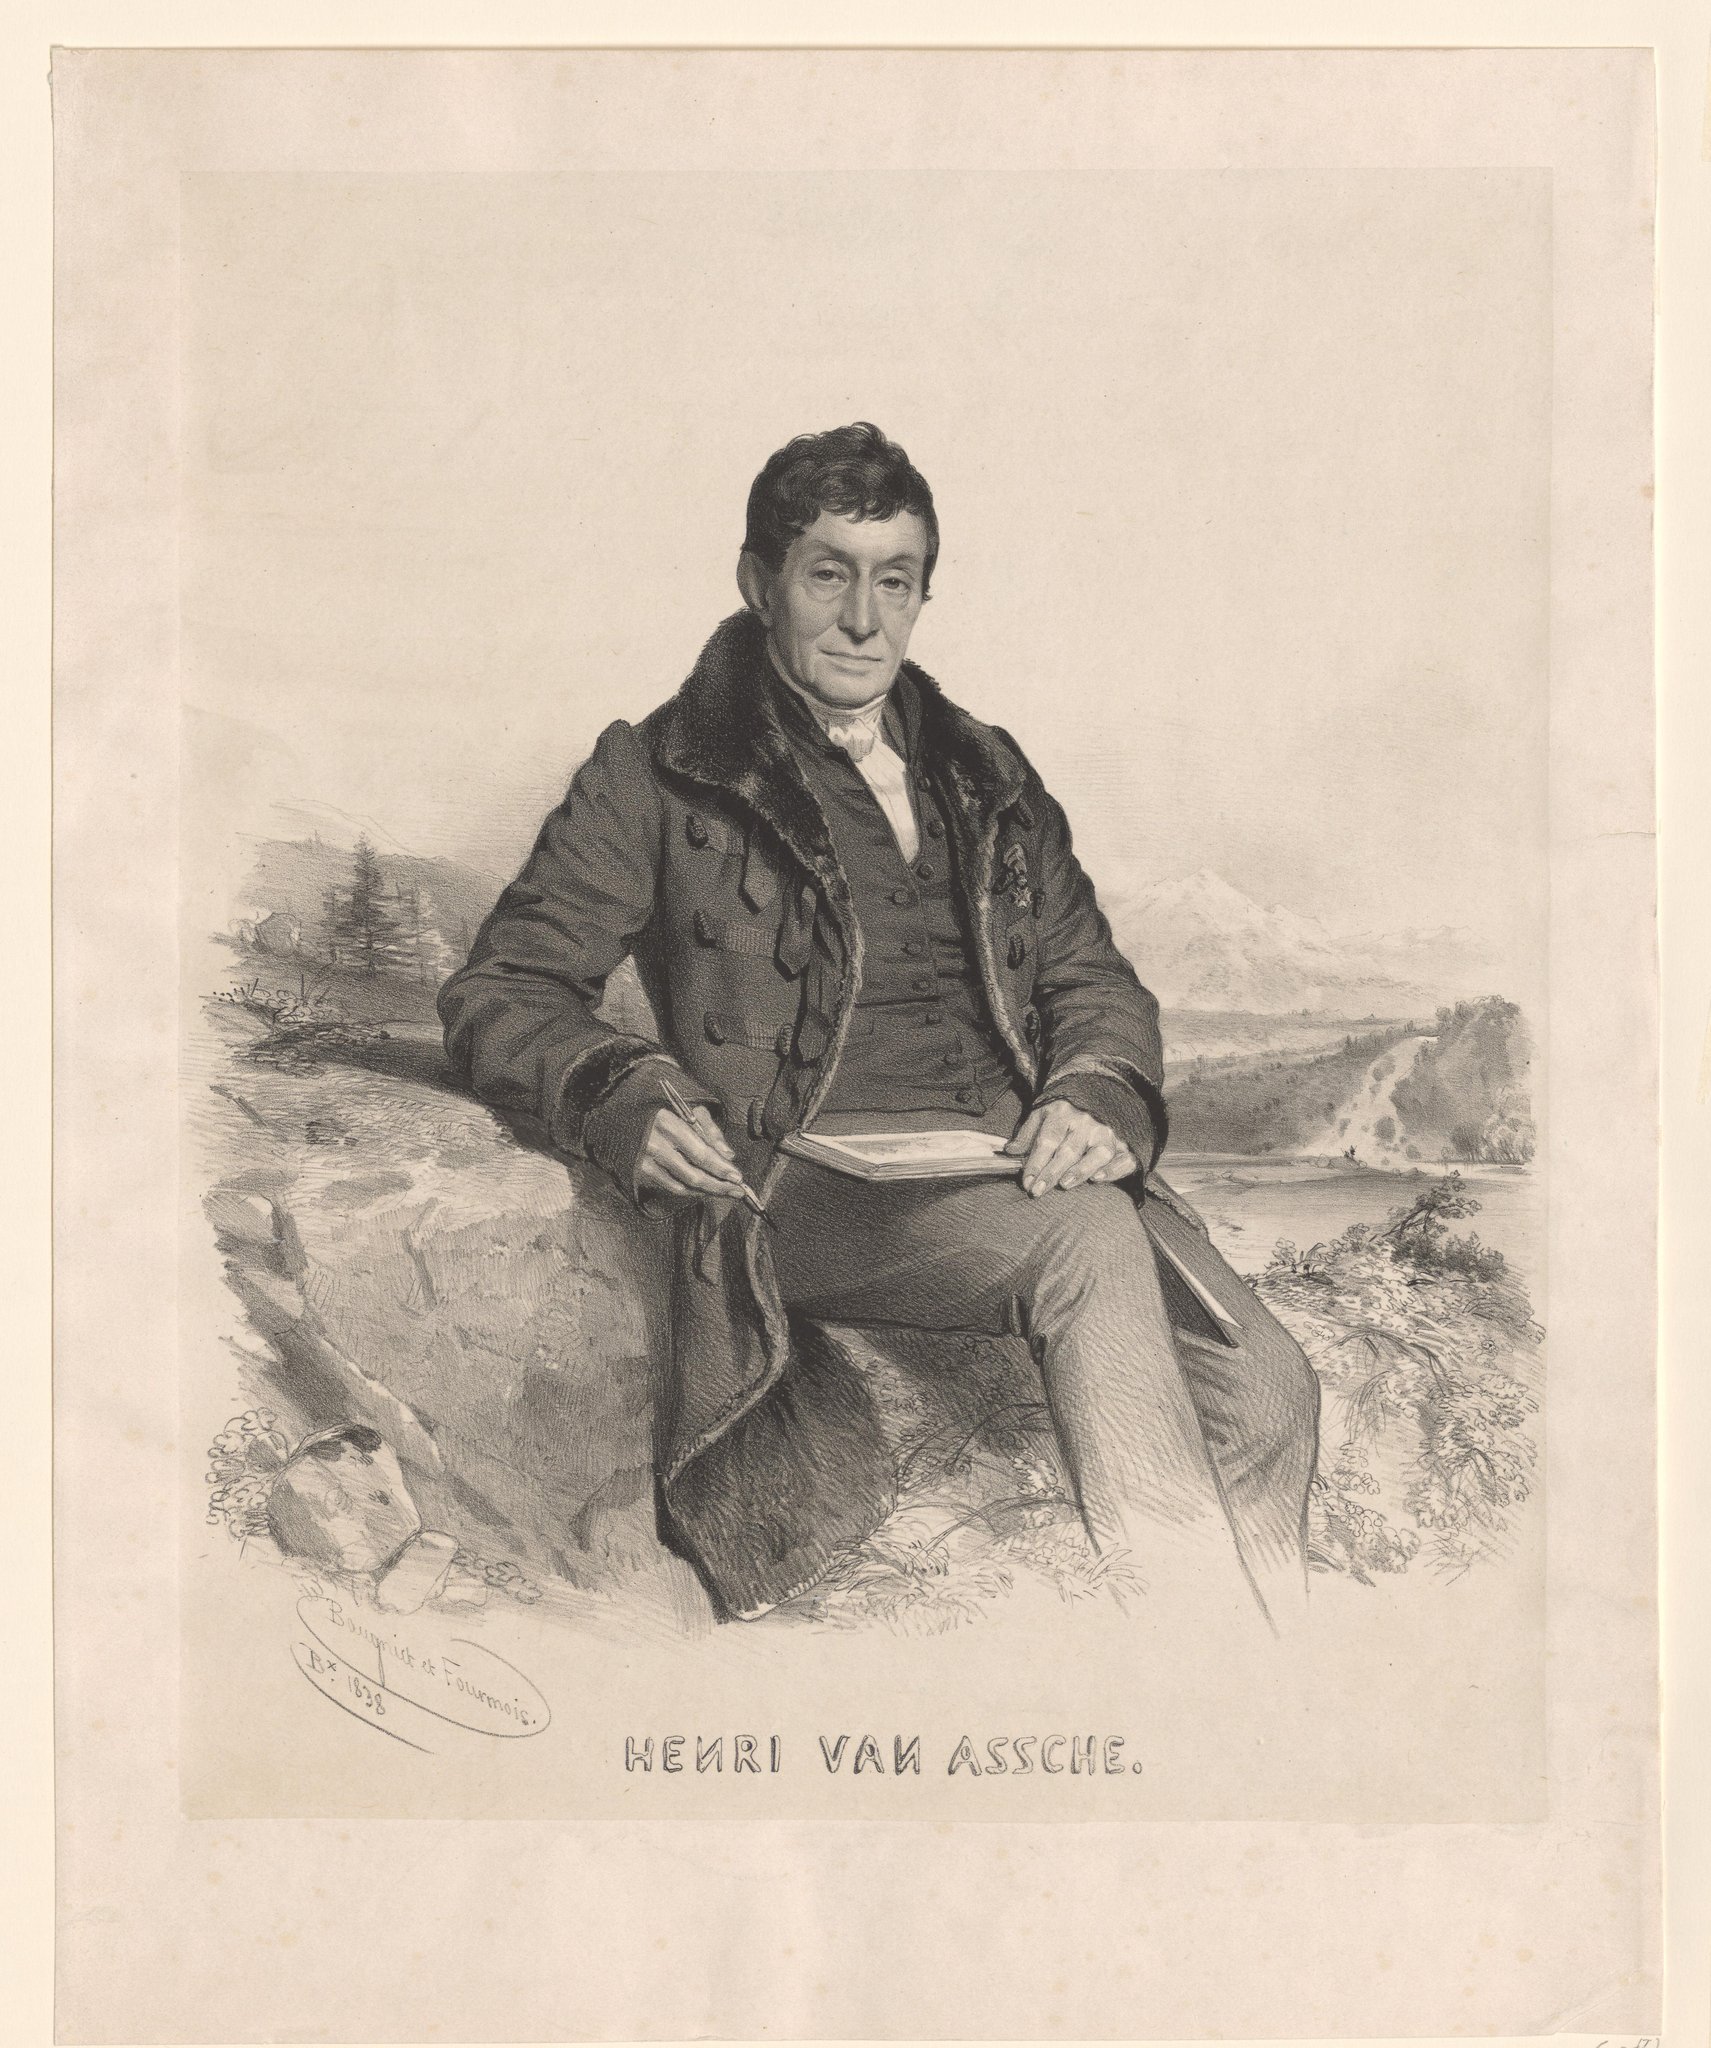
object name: print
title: Portret van Henri van Assche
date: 1838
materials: paper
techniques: lithograph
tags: henri van assche, landscapes, historical persons, portrait, self-portrait of painter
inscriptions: date